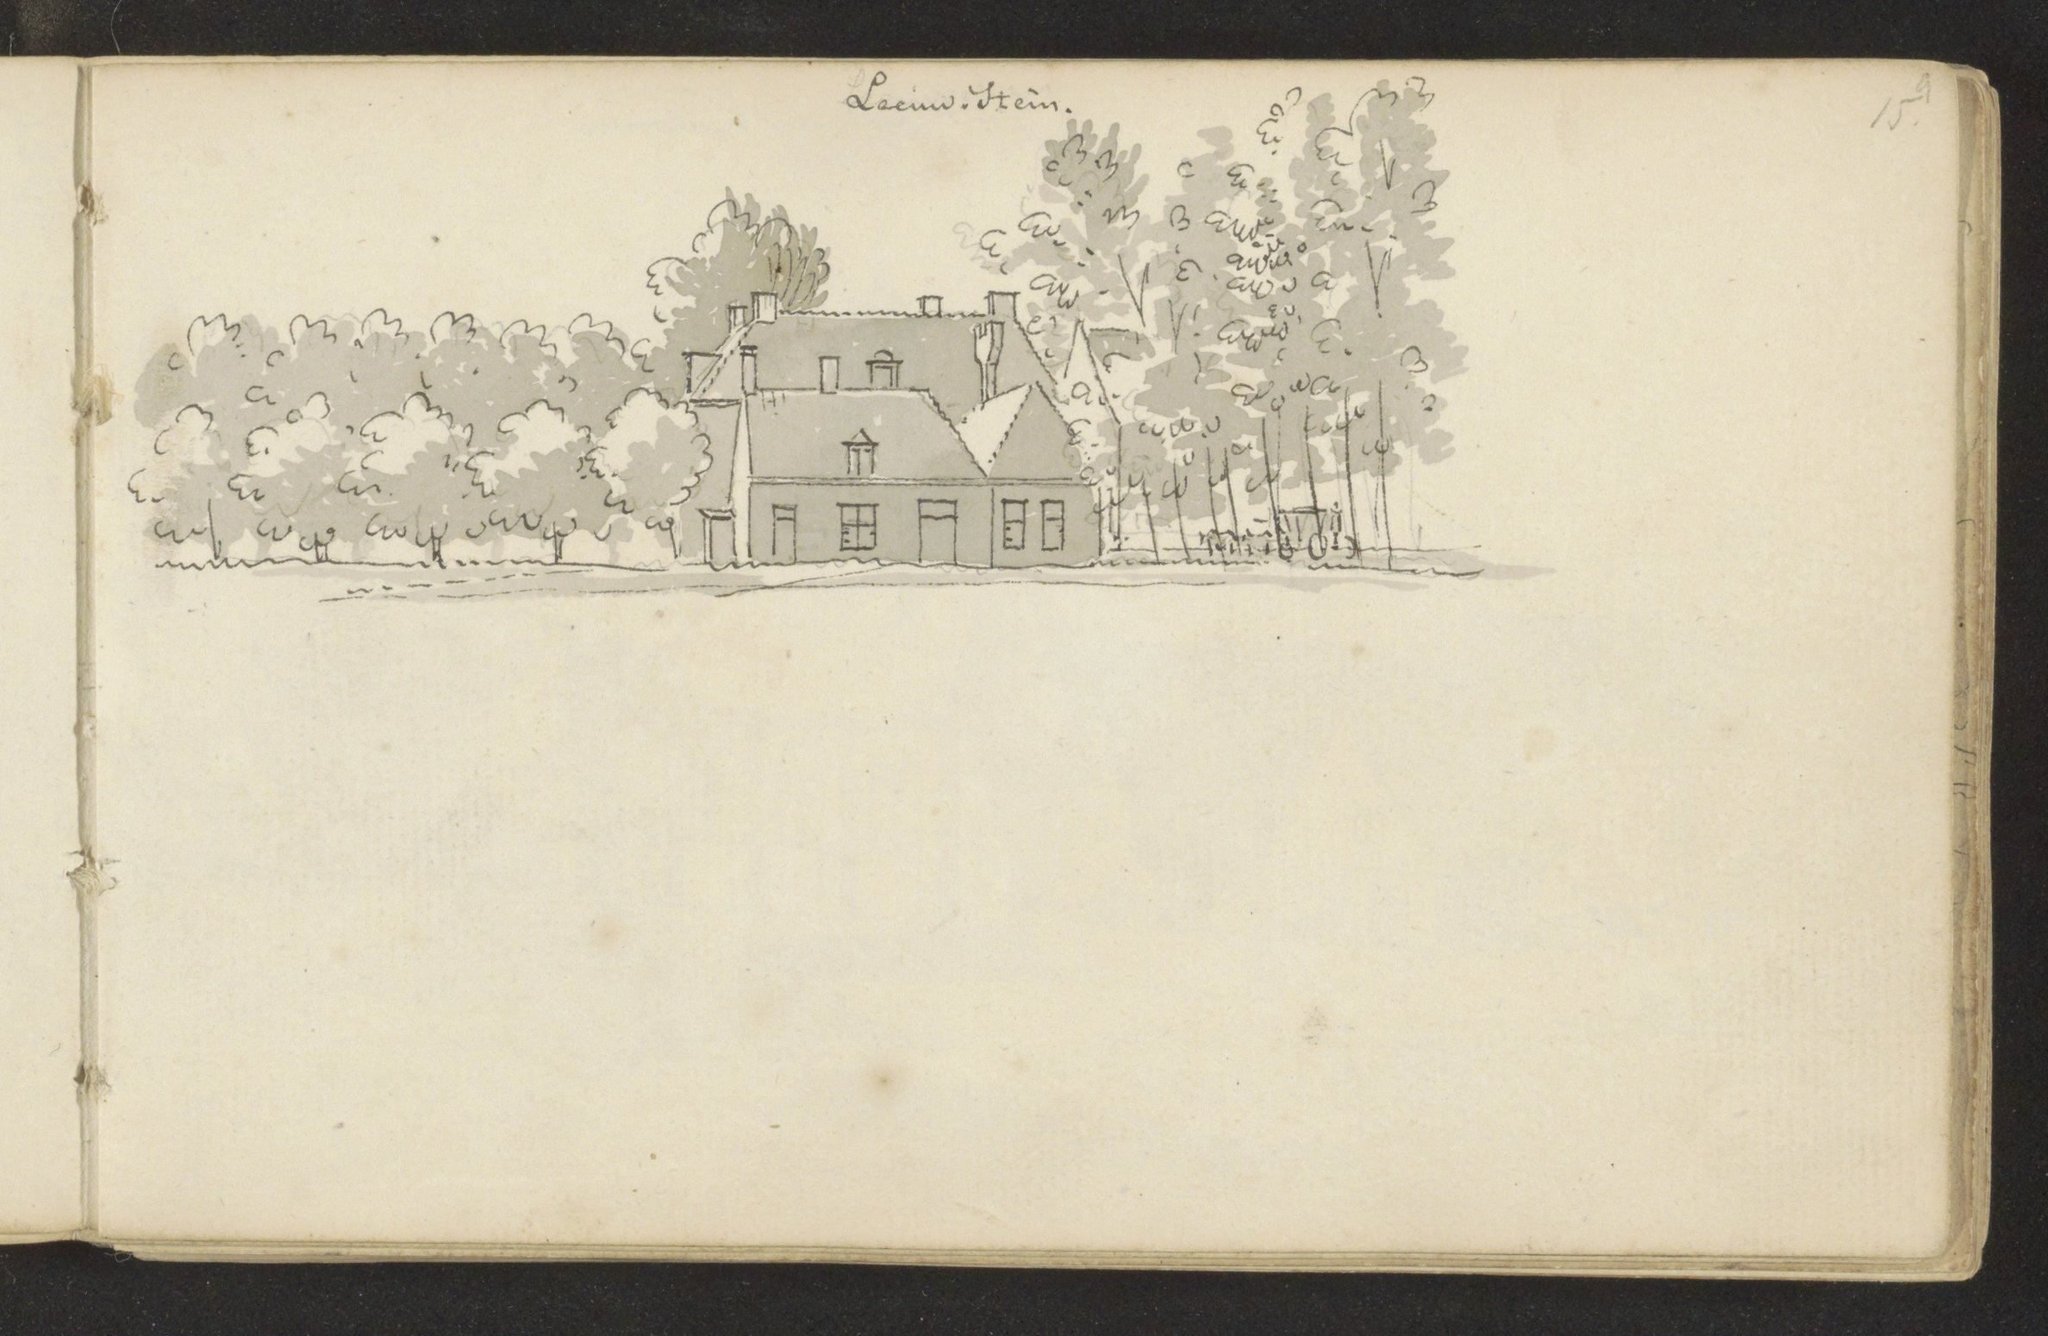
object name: sketchbook leaf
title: Huis Leeuwestein te Heenvliet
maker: abraham de haen (ii)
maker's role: draughtsman, print maker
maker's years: 1707-1748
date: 1731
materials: ink, paper, pencil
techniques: brush, pen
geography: heenvliet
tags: farm or solitary house in landscape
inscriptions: annotation: ‘Leeuw. Stein.’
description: Blad 15 recto uit een schetsboek met 78 bladen.